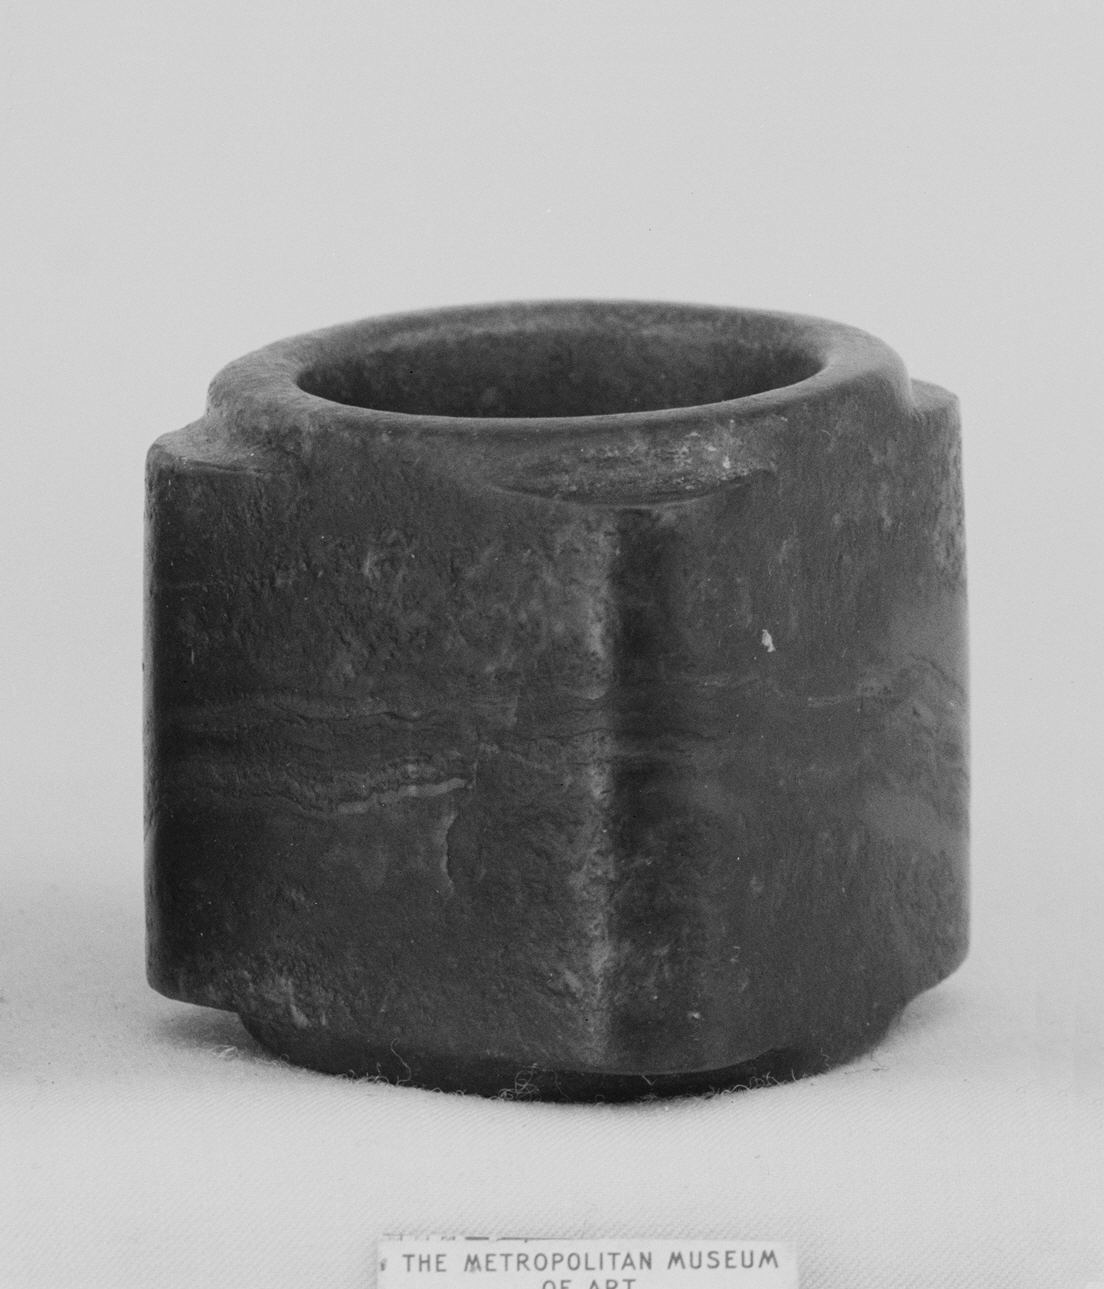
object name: religious ritual object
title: Ritual object (cong)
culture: chinese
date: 1867-1933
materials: jade